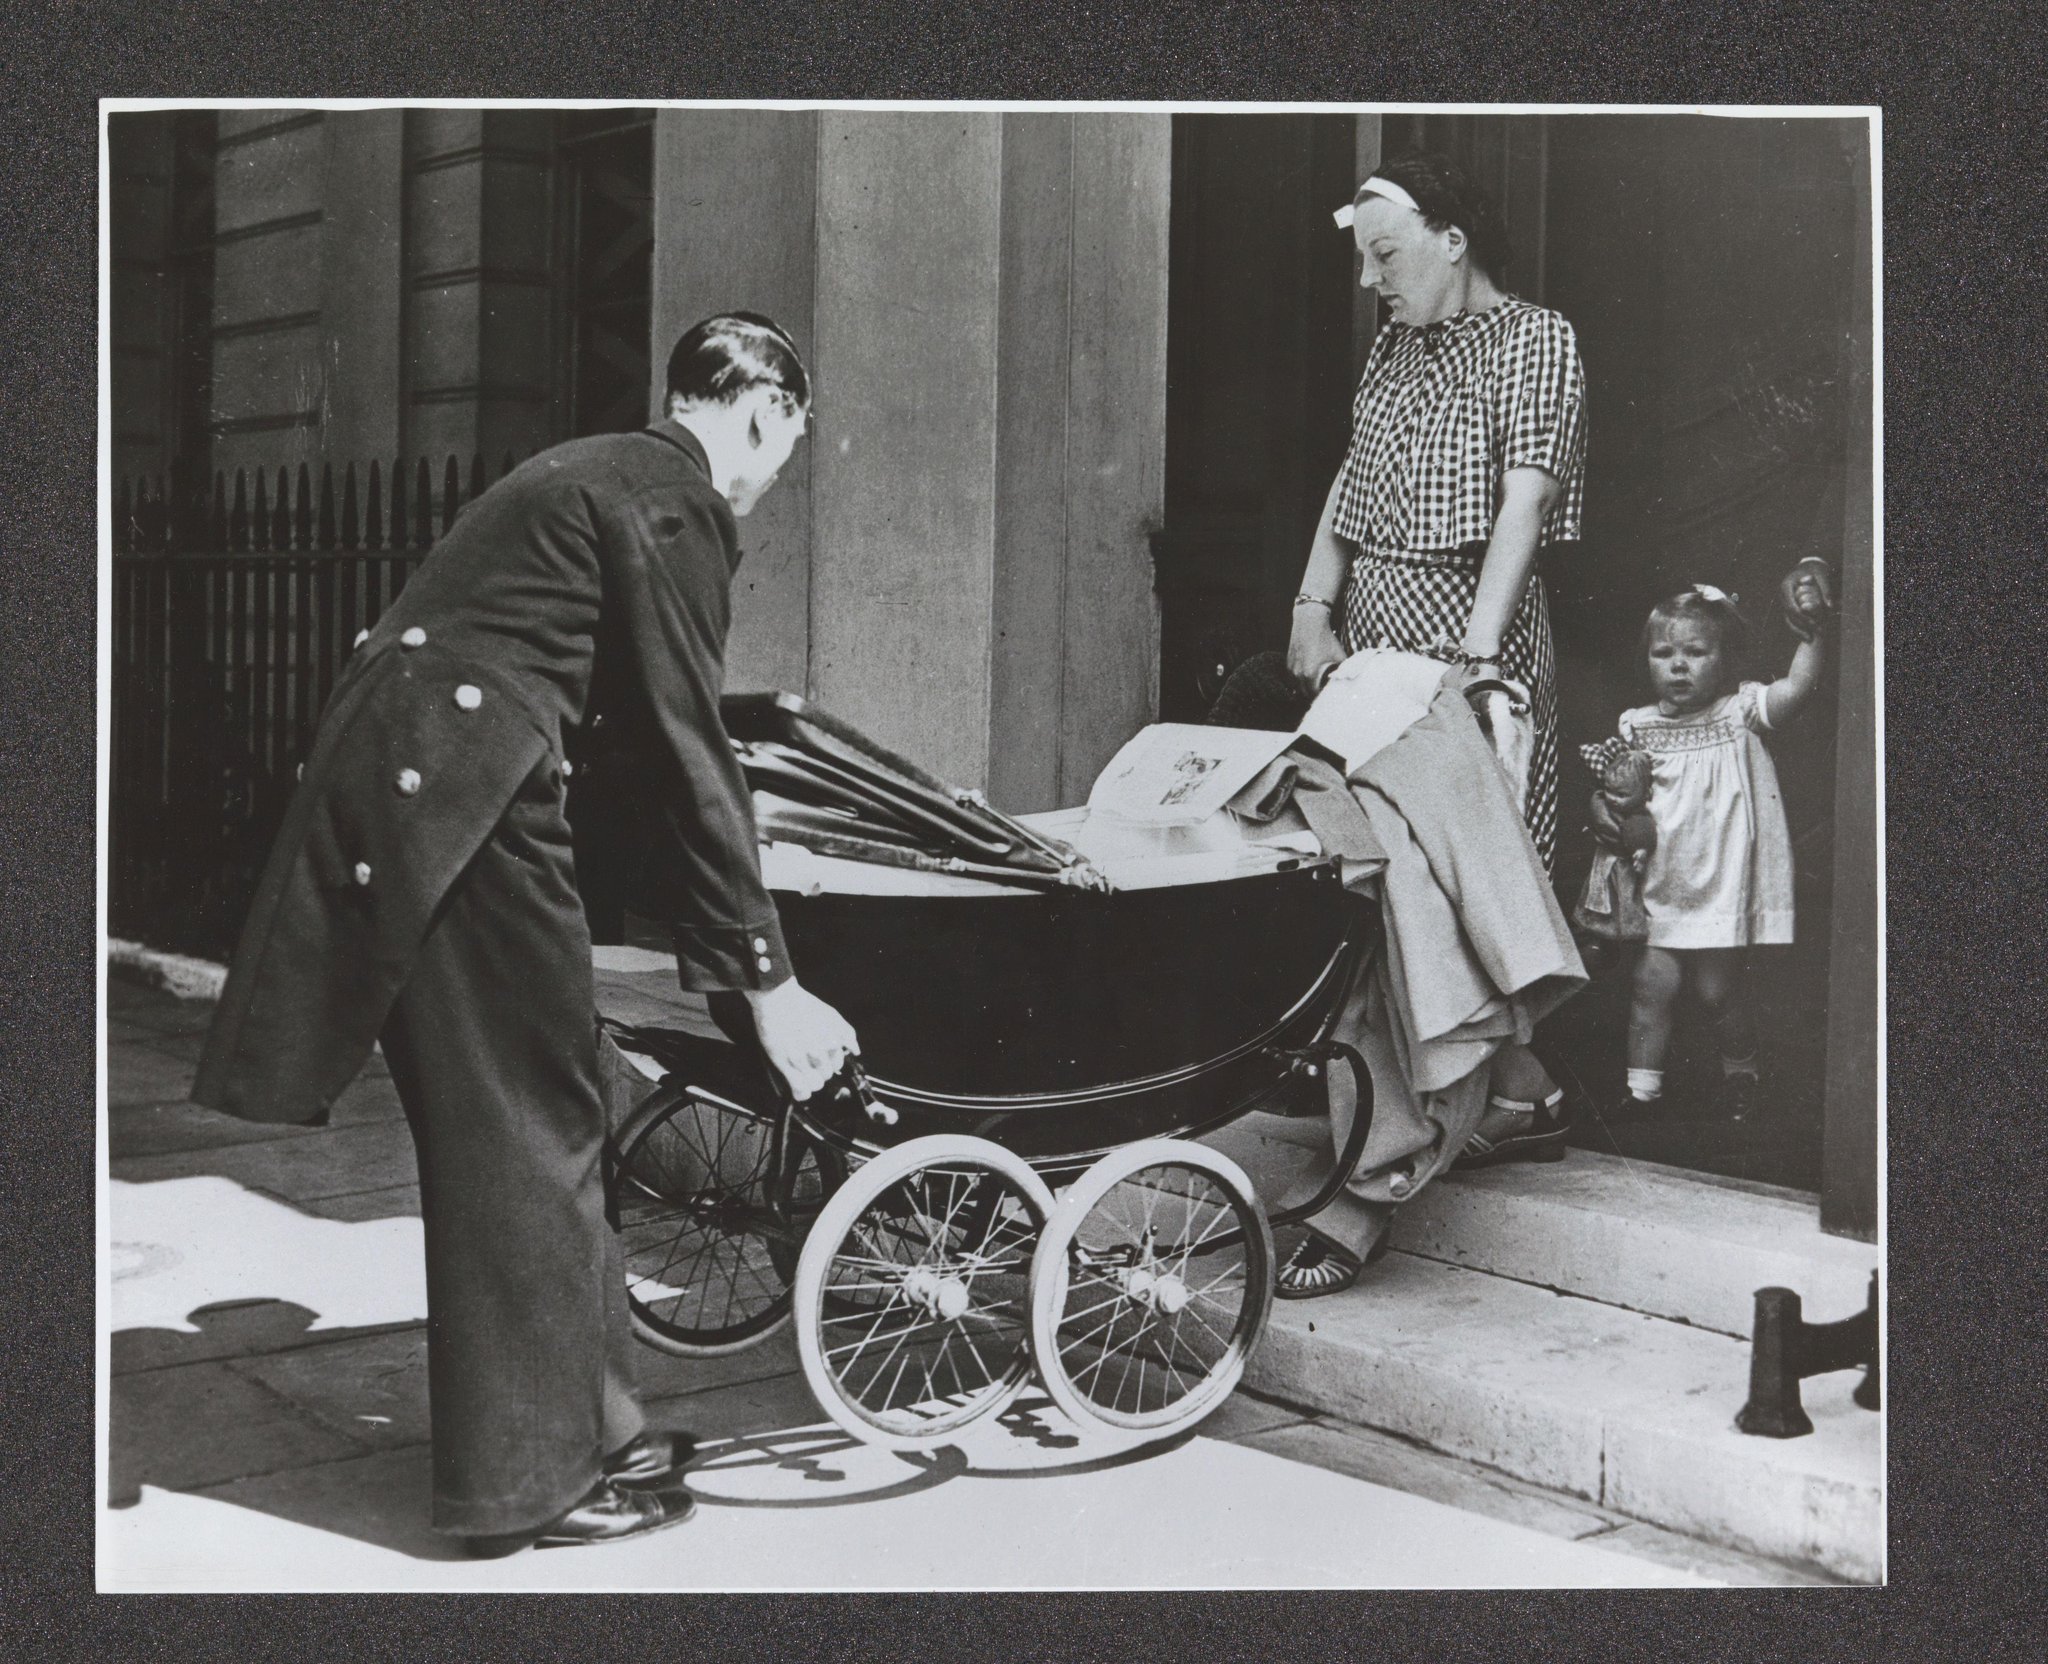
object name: photograph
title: Londen tegen oorlog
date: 1940-1945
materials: photographic support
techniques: gelatin silver print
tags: beatrix (koningin der nederlanden), the hague, juliana of the netherlands, london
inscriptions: stamp: ‘Copyright ANEFO Kerkstraat 310 Amsterdam-C PRF 22/9706’